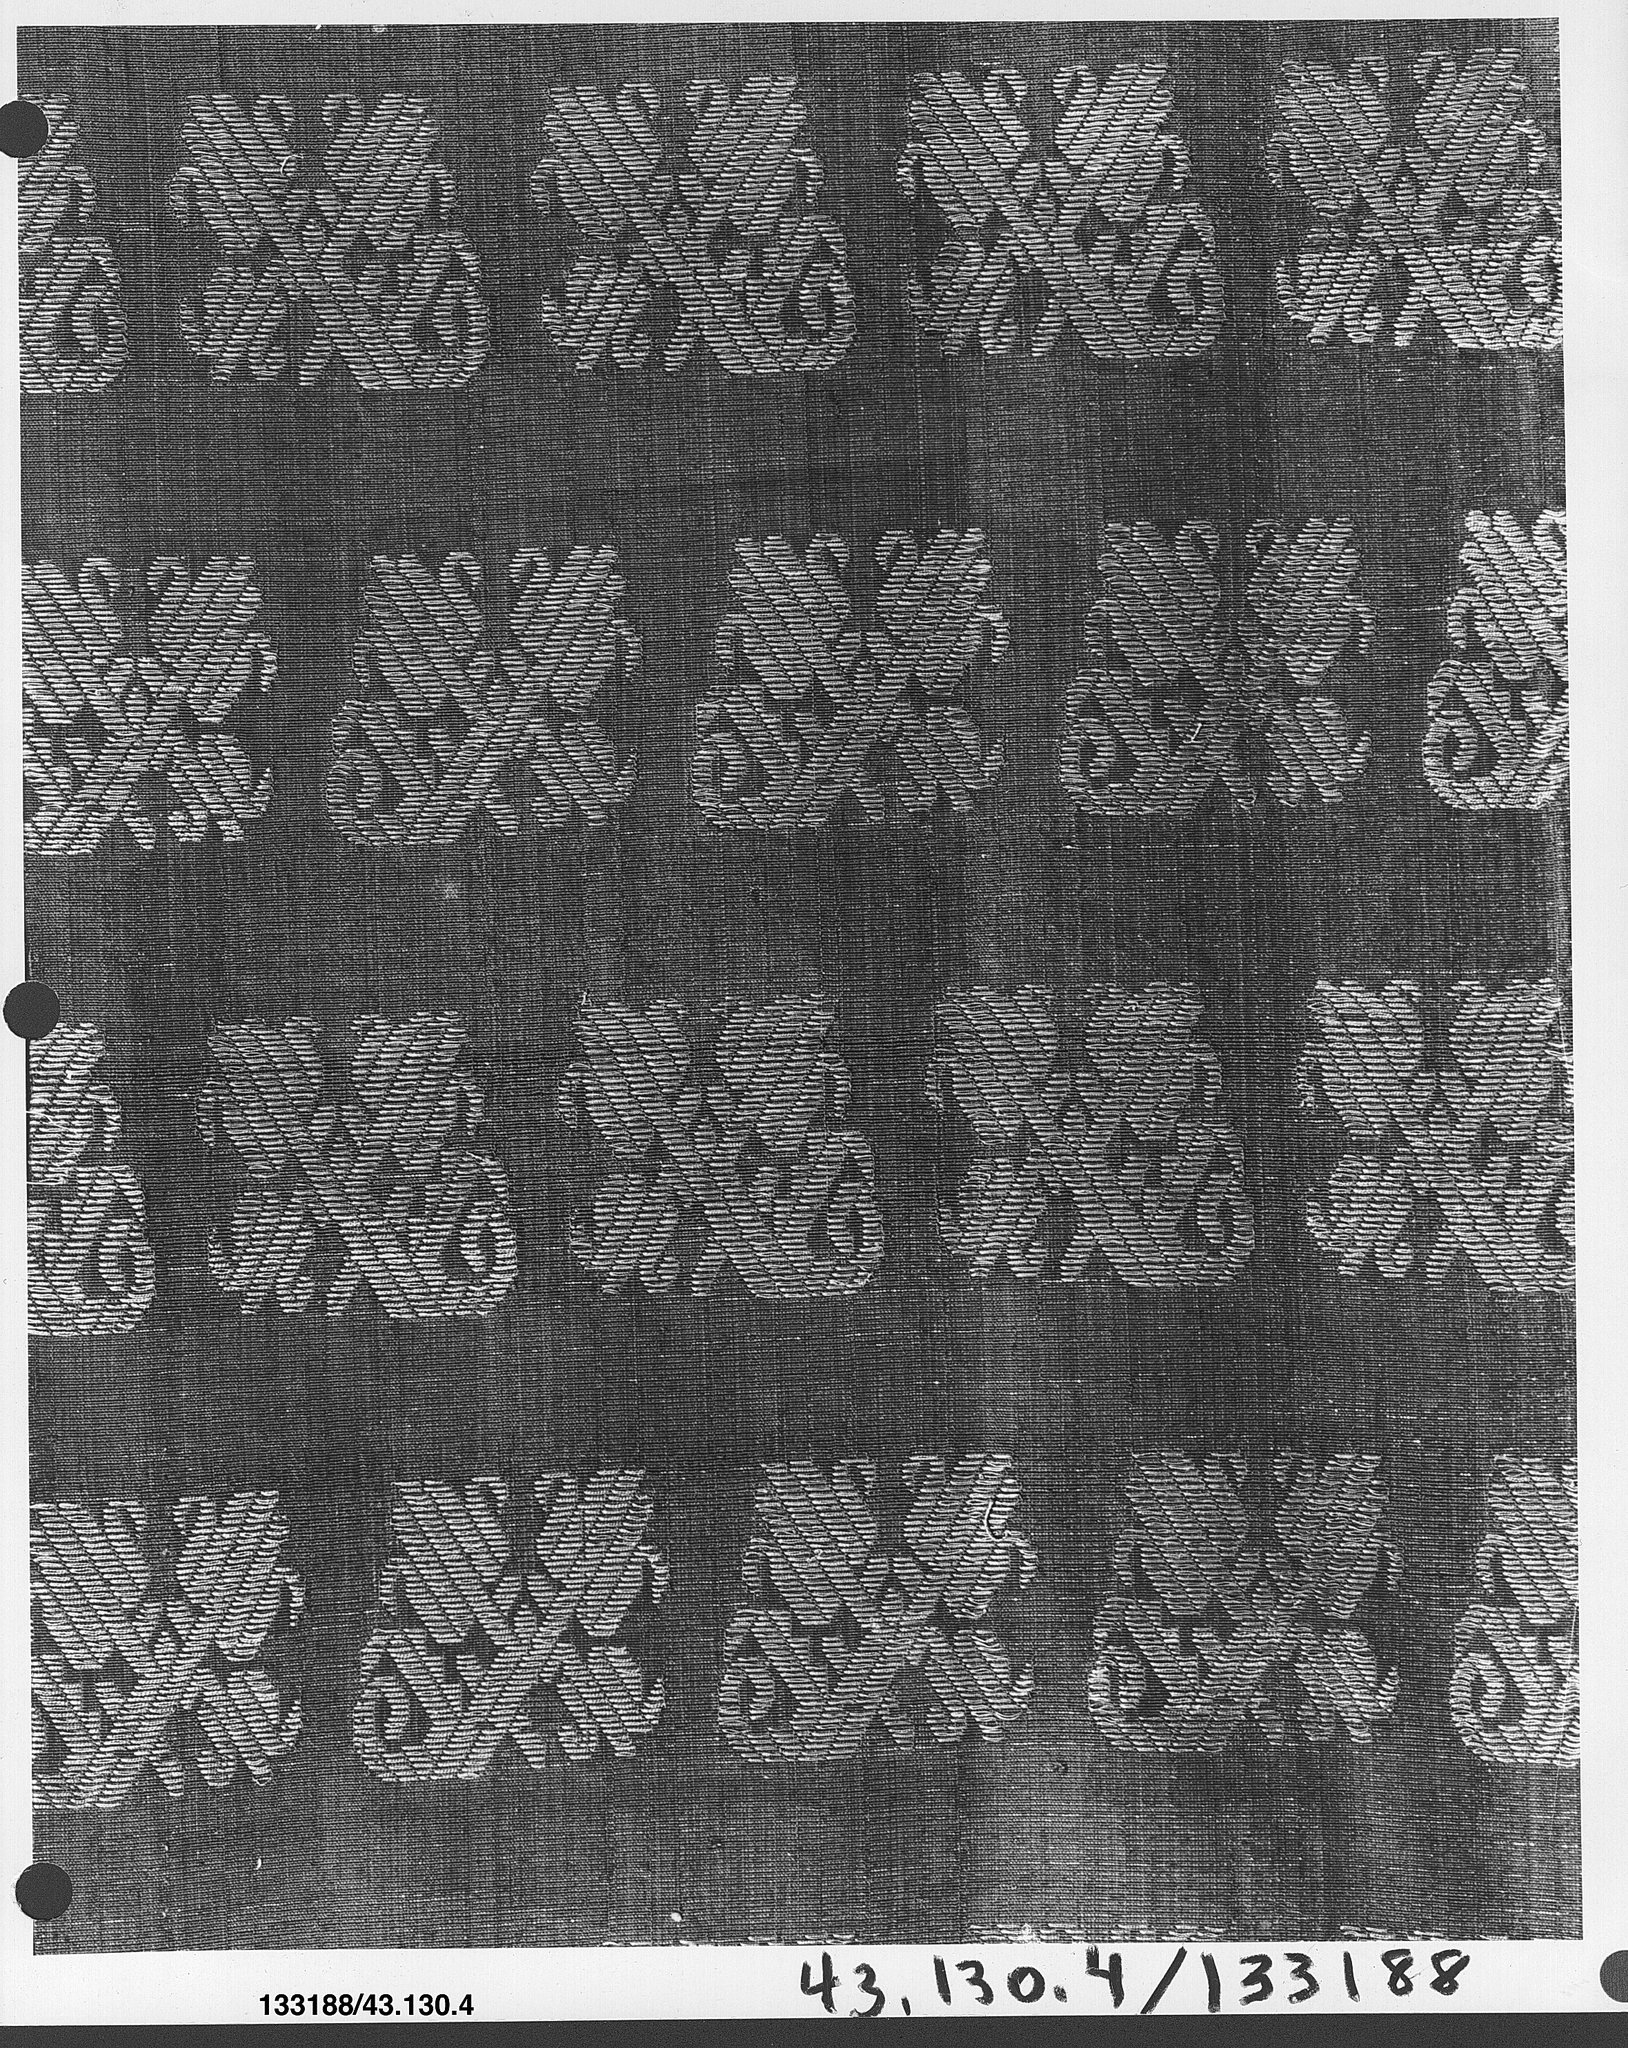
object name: piece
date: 1601-1700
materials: metal thread, silk